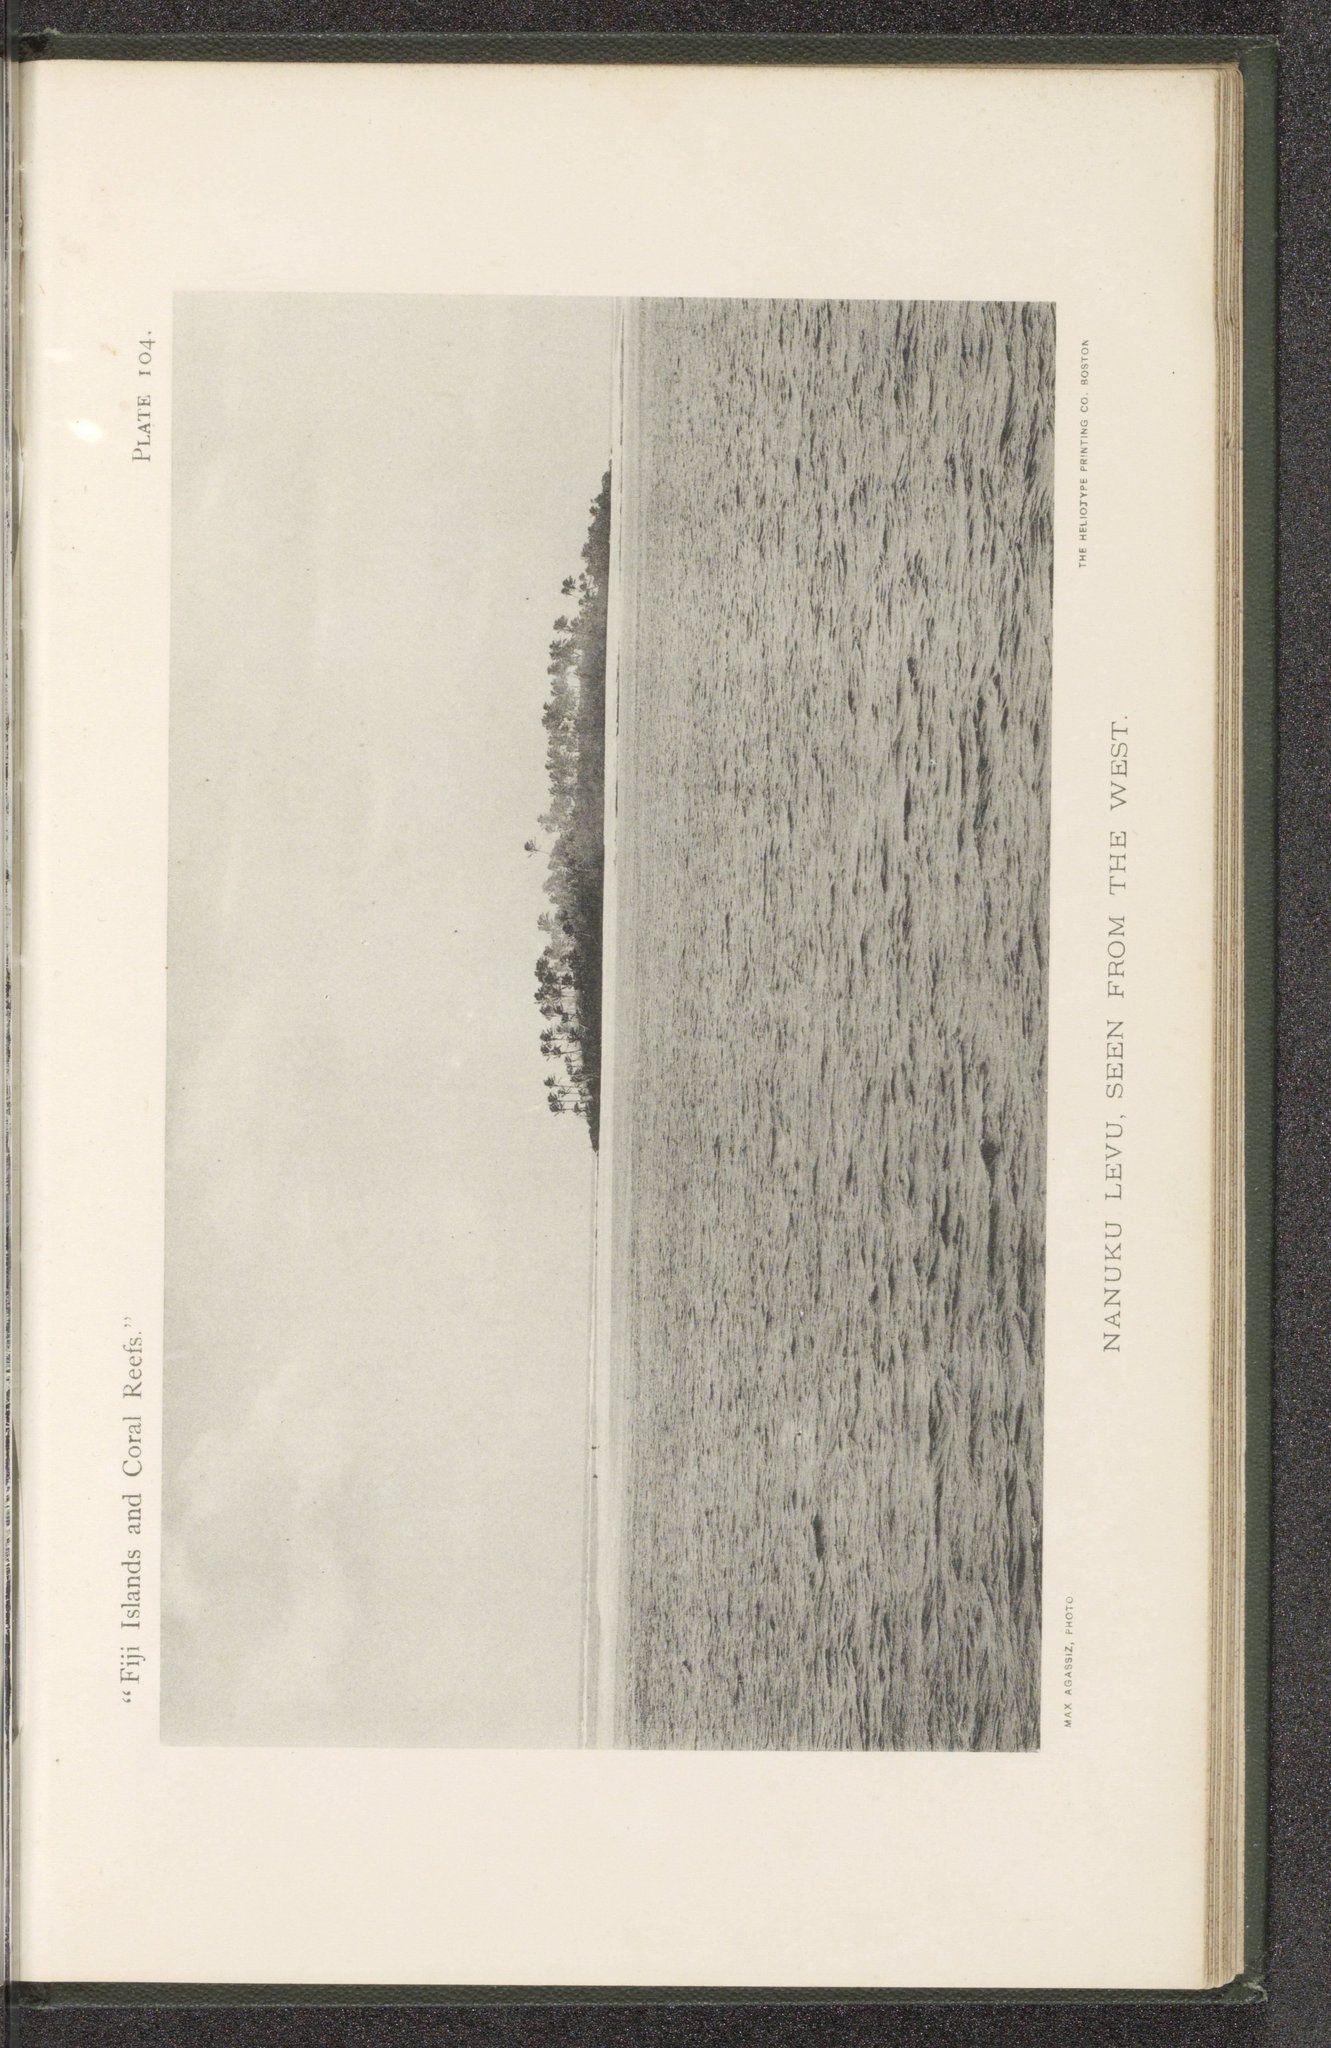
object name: photomechanical print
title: Nanuku Levu, seen from the west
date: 1885-1899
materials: paper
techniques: photograph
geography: boston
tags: island, ocean, trees: palm-tree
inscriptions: name: ‘Max Agassiz, Photo.’, name: ‘The Heliotype Printing Co. Boston’, number: ‘Plate 104.’